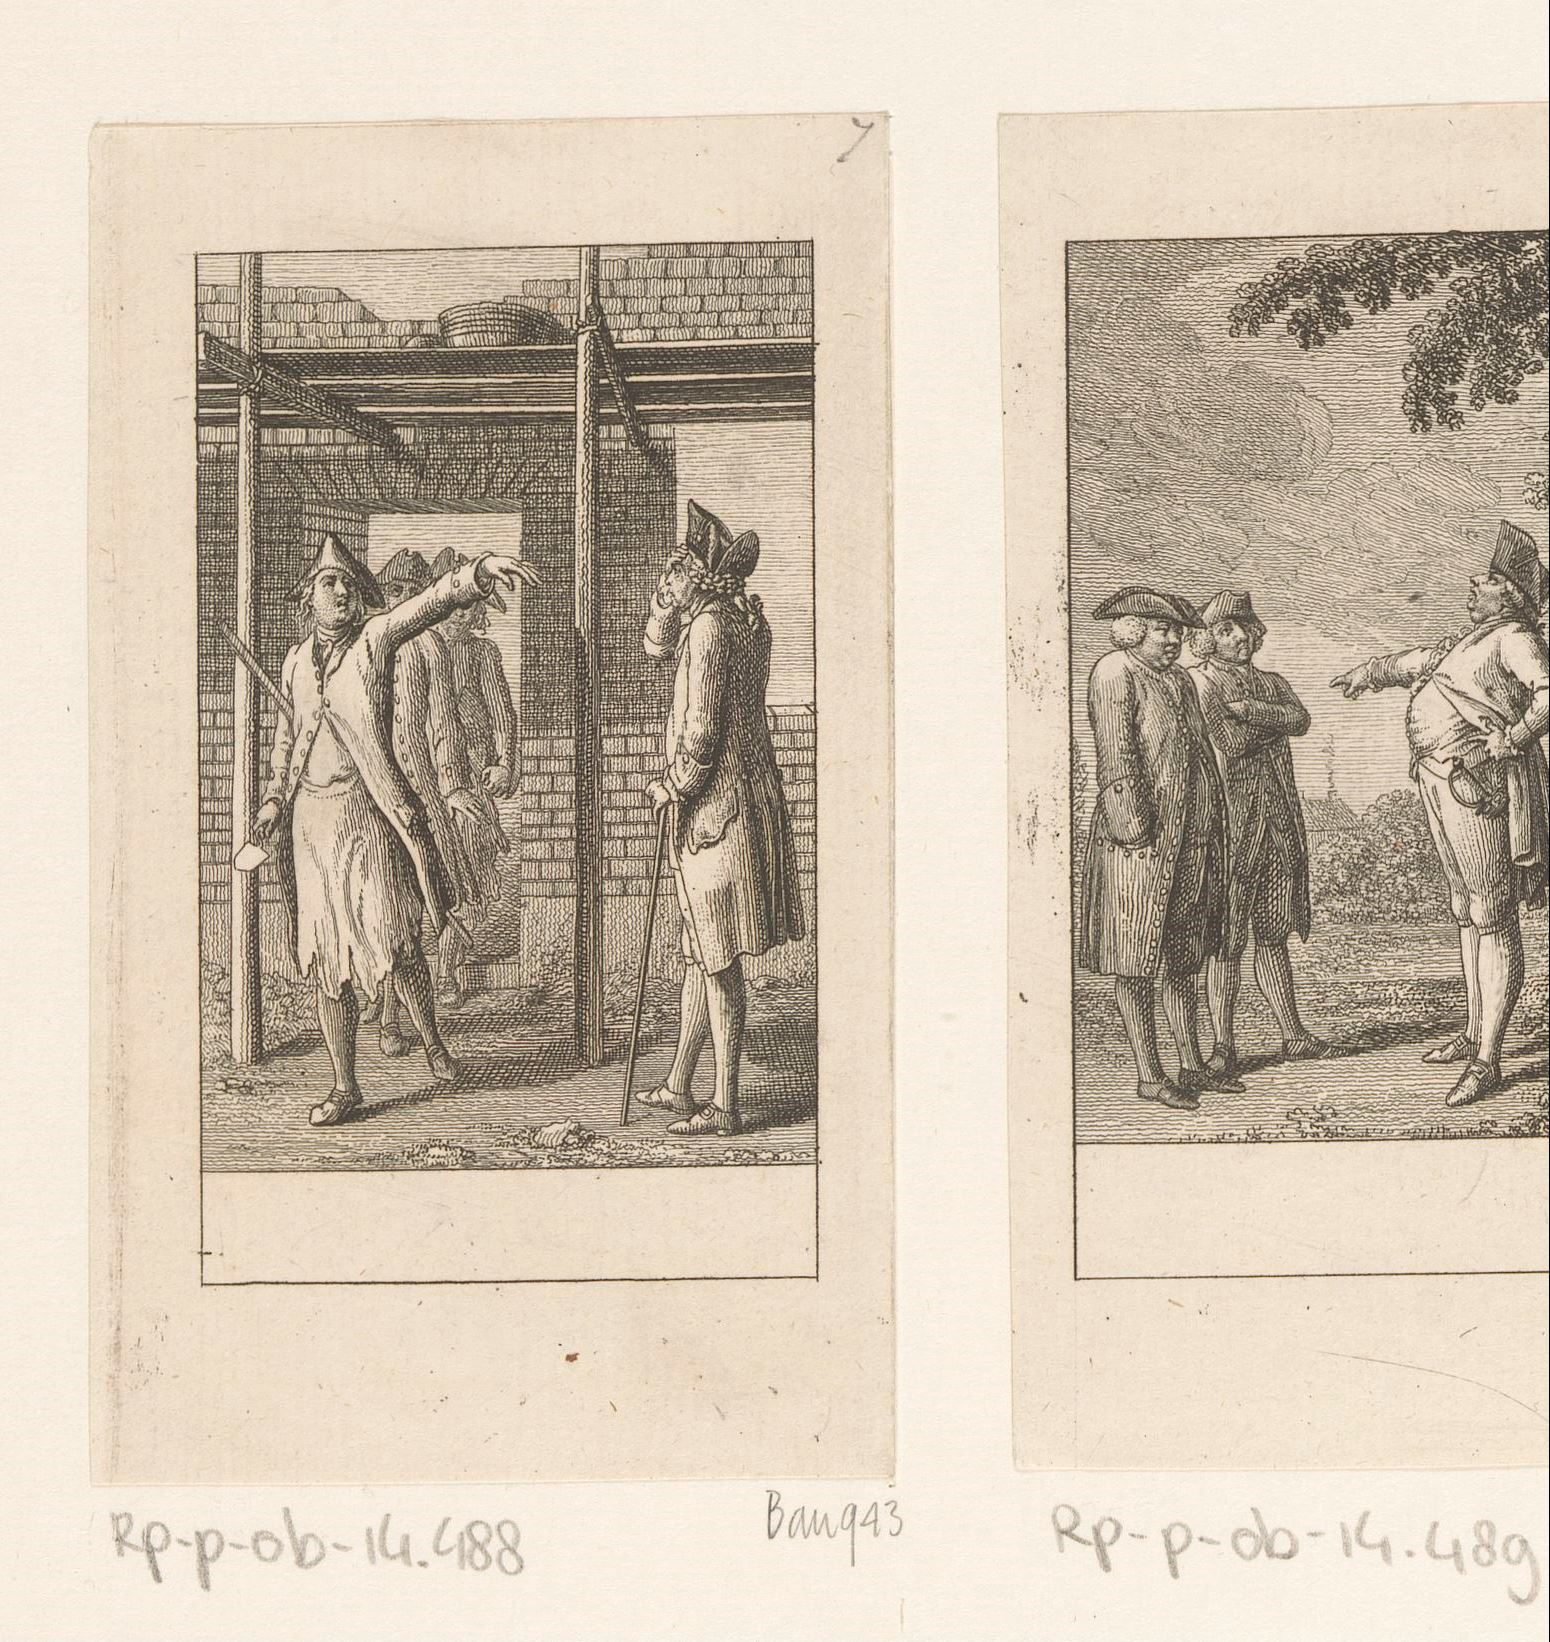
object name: print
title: Dwaasheid van de bouwdrang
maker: daniel nikolaus chodowiecki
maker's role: draughtsman, print maker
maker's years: 1726-1801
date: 1782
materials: paper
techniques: etching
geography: berlin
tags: architectural folly, building-site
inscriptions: collector's mark: Lugt 2228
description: Vervaardigd voor Sancta Clara's 'Centifolium Stultorum'. Latere staat gebruikt voor: Goettinger Taschen Calender vom Jahr 1783. bey Joh. Chr. Dietrich. Göttingen: Georg Christoph Lichtenberg, 1782.